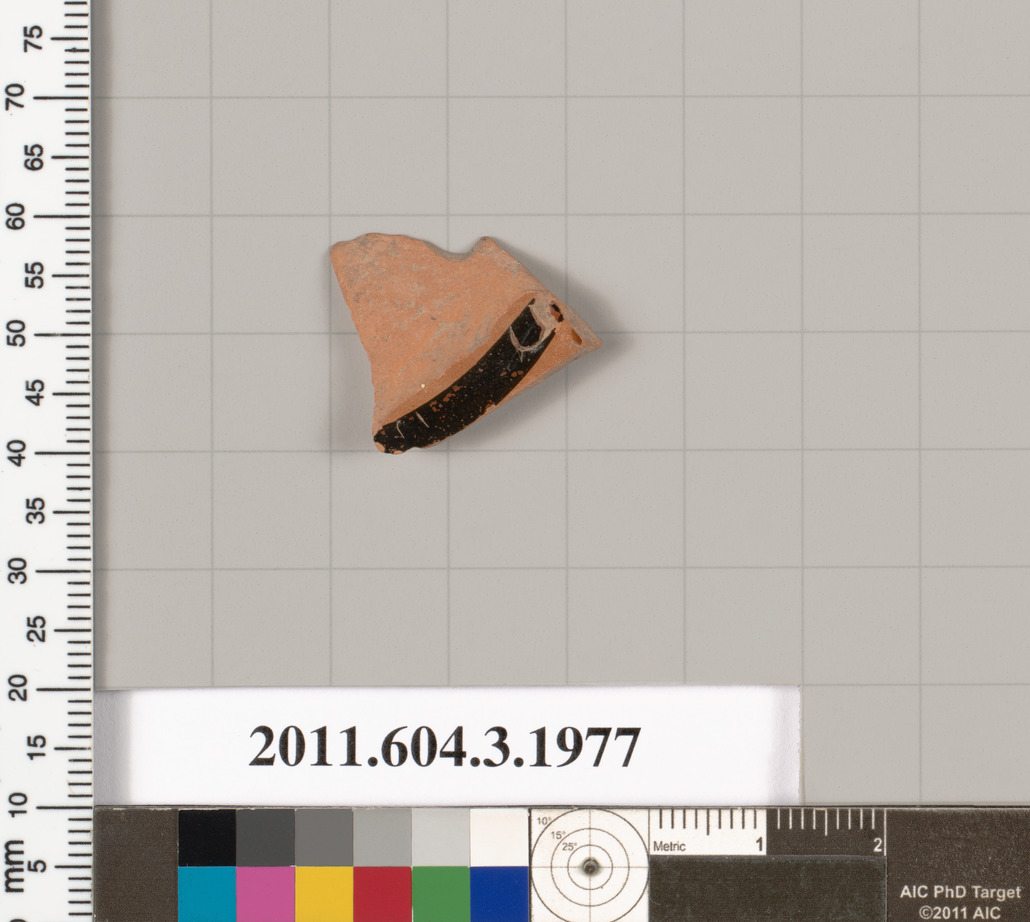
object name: kylix fragment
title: Terracotta fragment of a kylix (drinking cup)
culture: greek, attic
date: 600-501 BCE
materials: terracotta